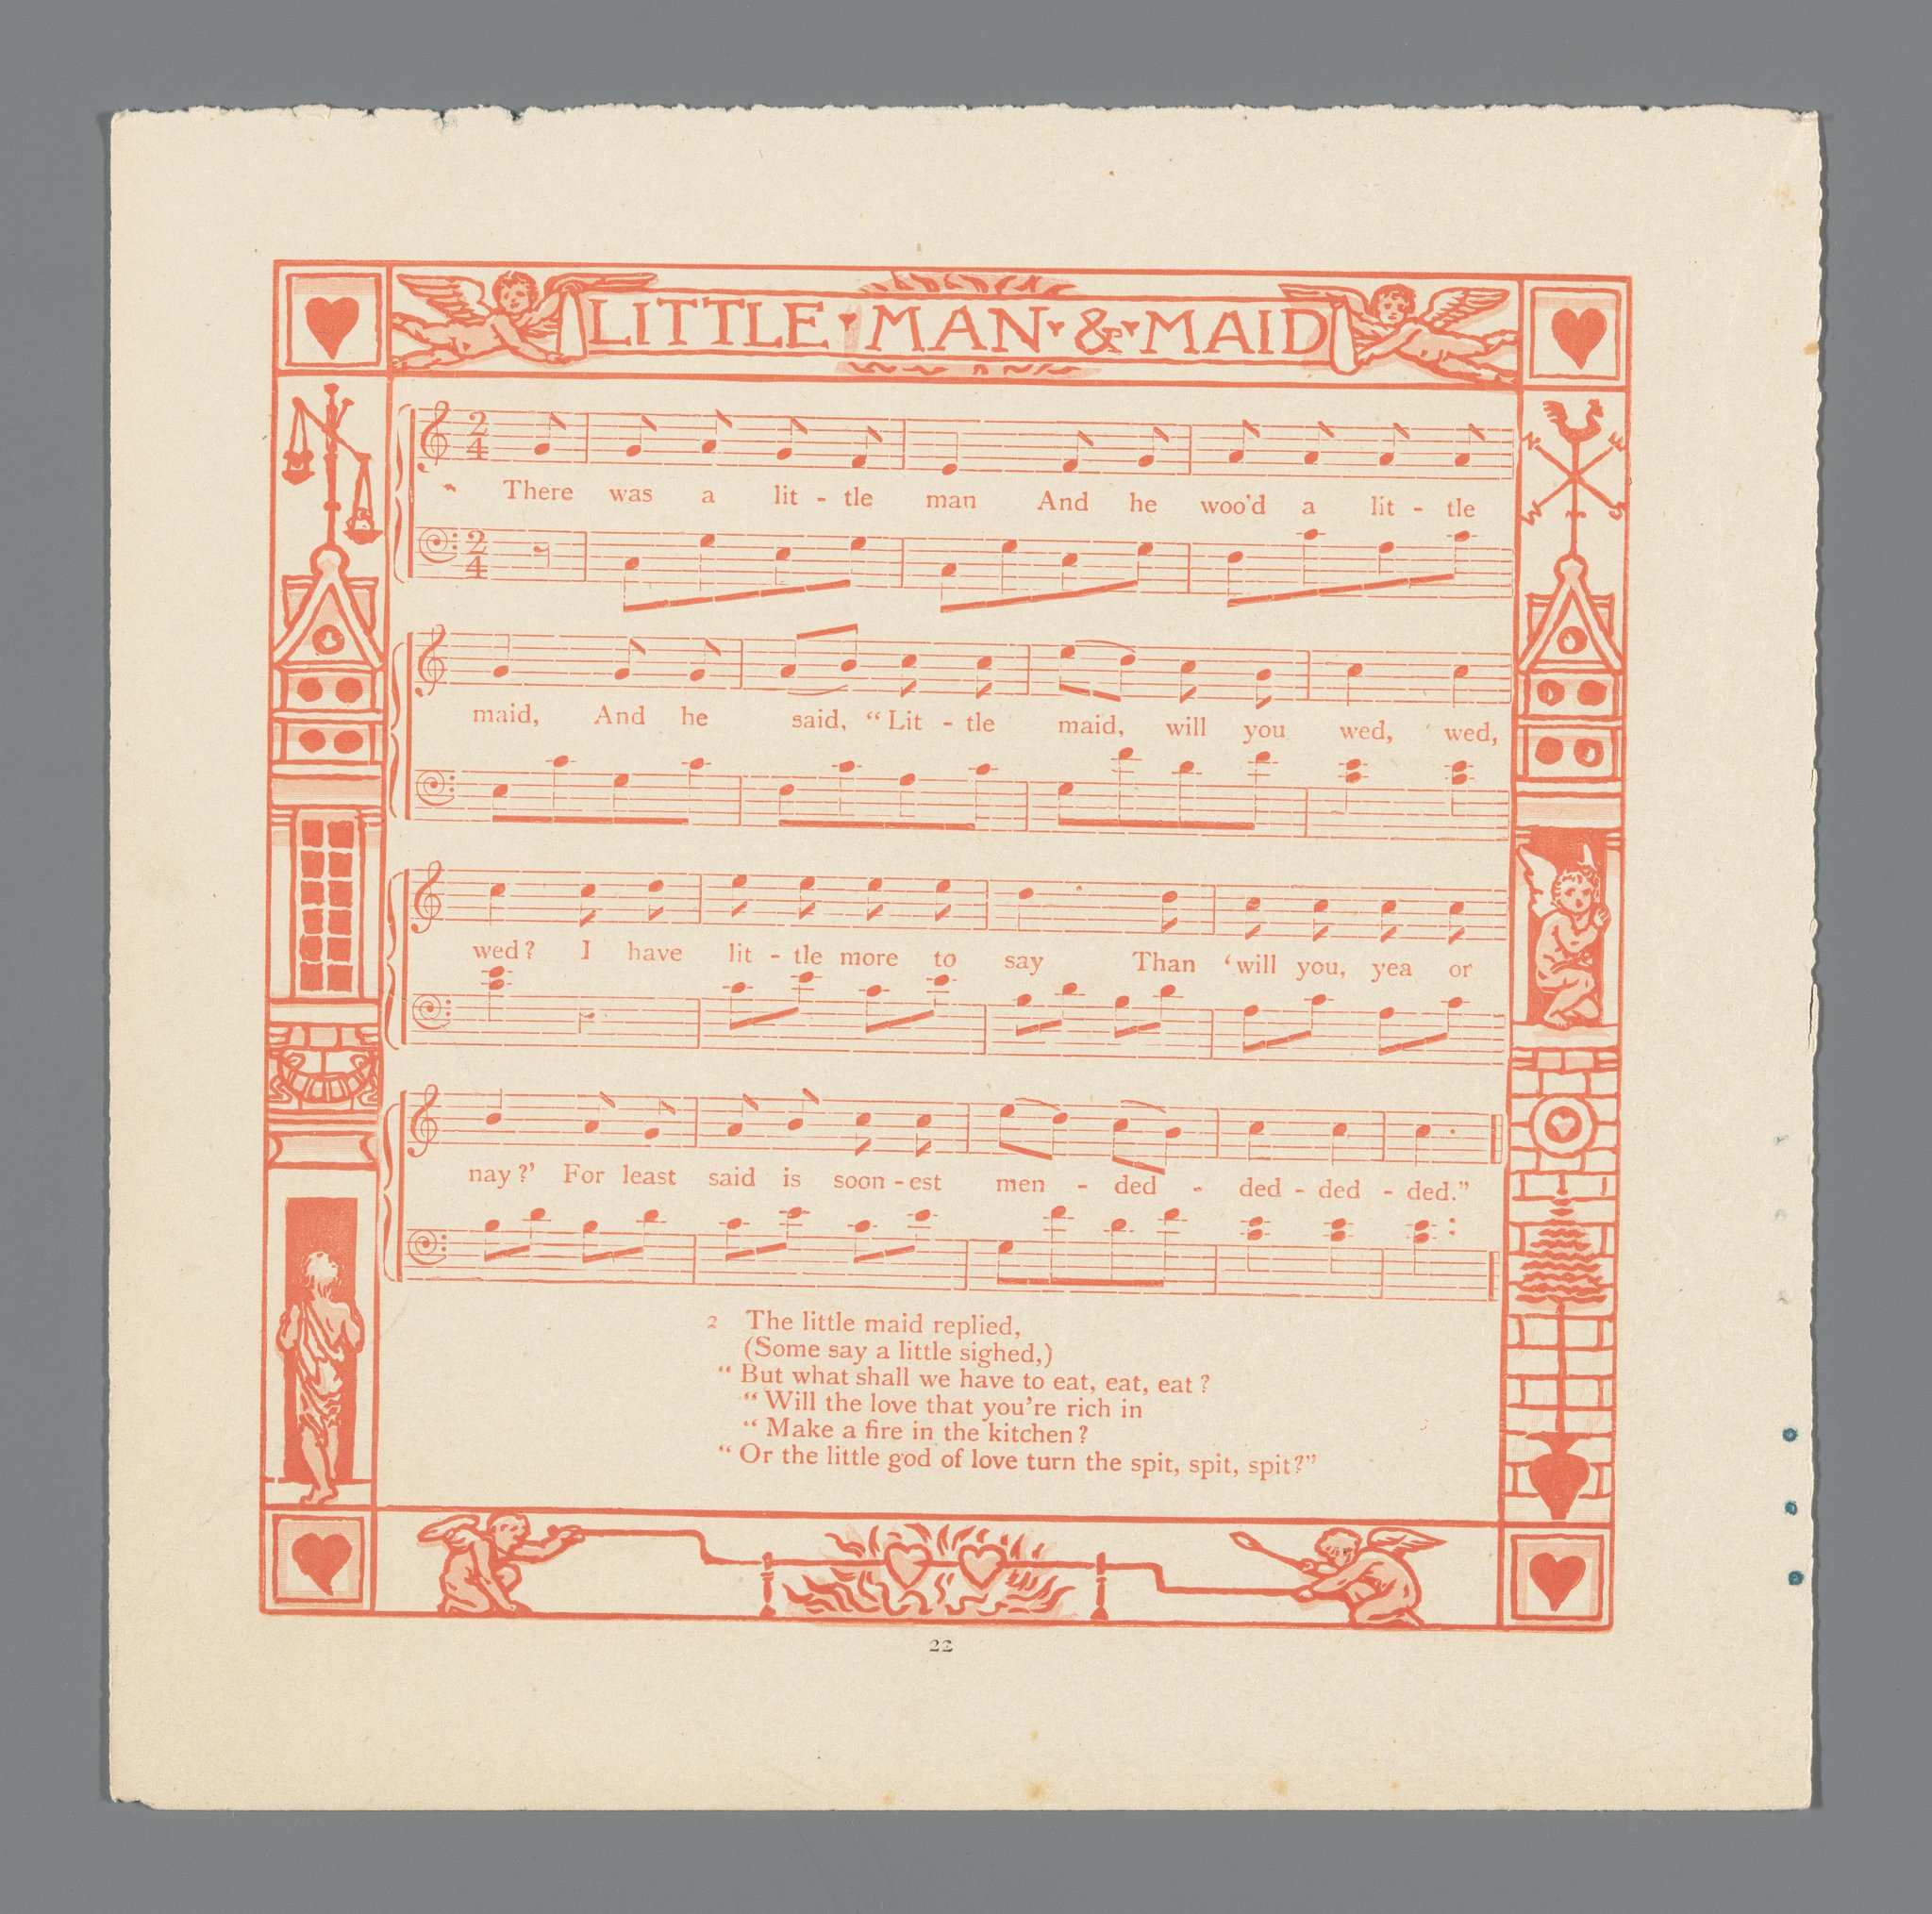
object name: print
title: Bladmuziek met gevels en putti die harten in het vuur houden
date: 1878-1927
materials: paper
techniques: letterpress printing, engraving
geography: london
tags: heart, civic architecture; edifices; dwellings, cupids: 'amores', 'amoretti', 'putti'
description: Prent uit: The baby's bouquet, a fresh bunch of old rhymes and tunes. Londen: Routledge & Sons, [1878]. Of een latere uitgave.